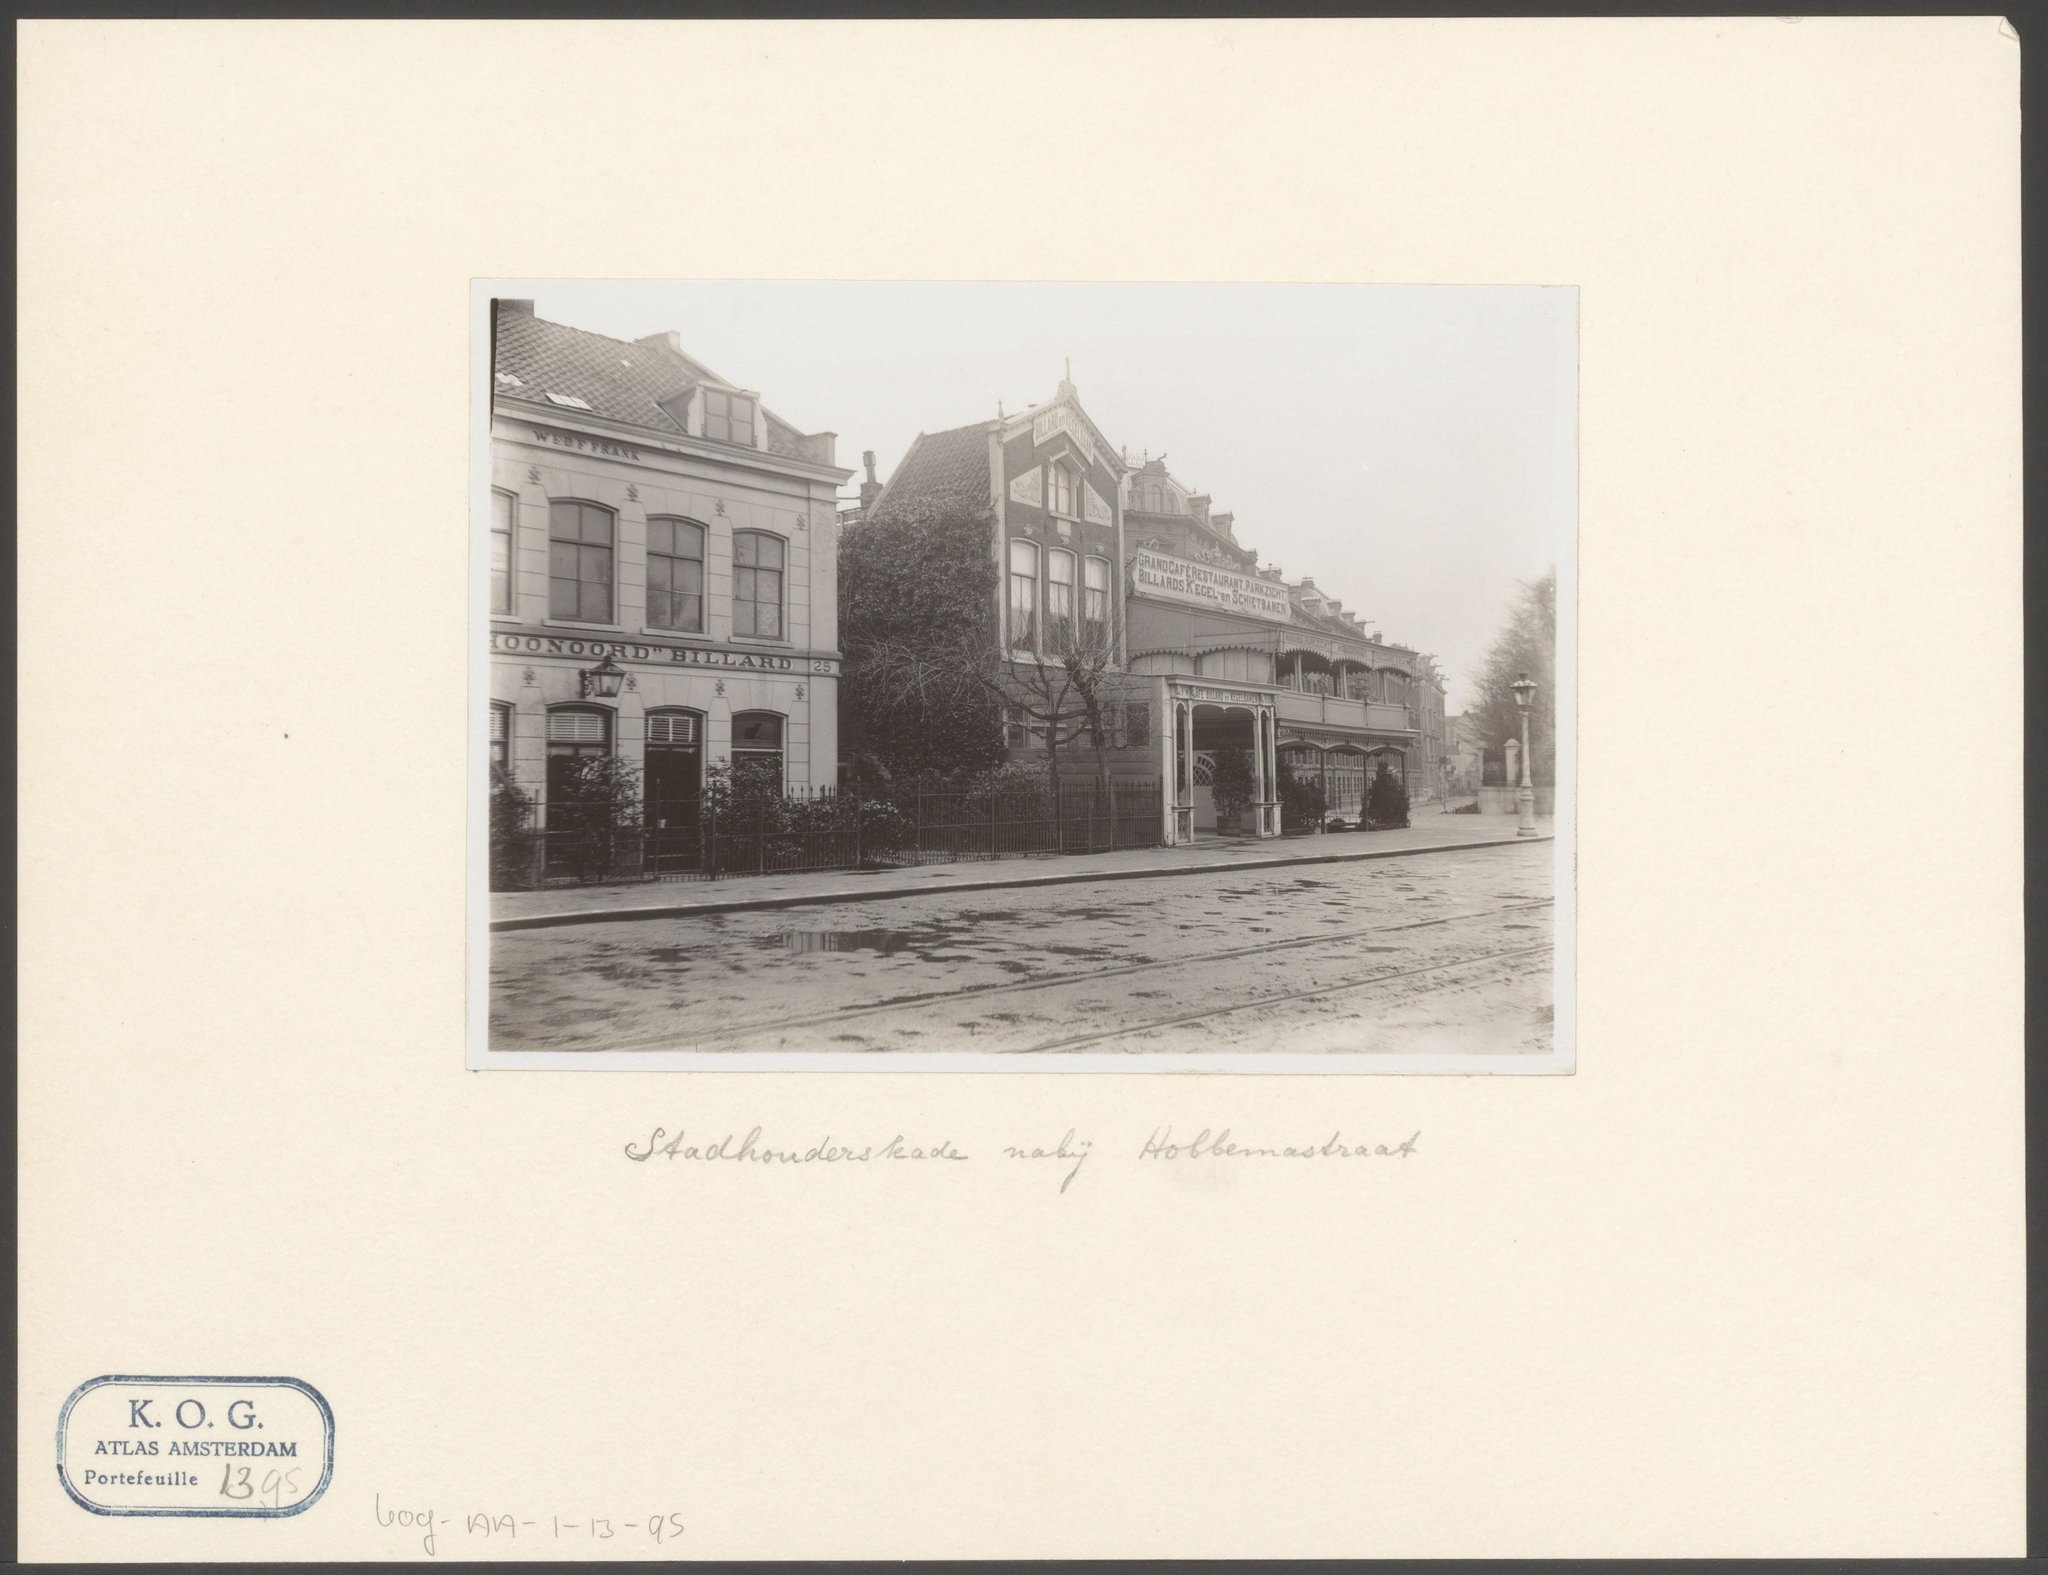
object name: photograph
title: Gezicht op de Stadhouderskade nabij de Hobbemastraat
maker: Anonymous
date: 1880-1950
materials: paper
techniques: gelatin silver print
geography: amsterdam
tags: tramway, tram, city-view in general; 'veduta', the usual house or row of houses, street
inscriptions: inscription: ‘Stadhouderskade nabij Hobbemastraat’, collector's mark: ‘13,95’ Lugt 1641b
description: Onderwerpsrubriek binnen de Atlas Amsterdam: Slatuinenpad, Sloterkade, Slootstraat, Slijkstraat, Snoekjesgracht, Sophiapark, Spaarndammerdijk, Spiegelgracht, Spinhuissteeg, Spui, Spuistraat (ook lage Erf), Staalstraat, Stadhouderskade, Steenpad, Stroomarkt.